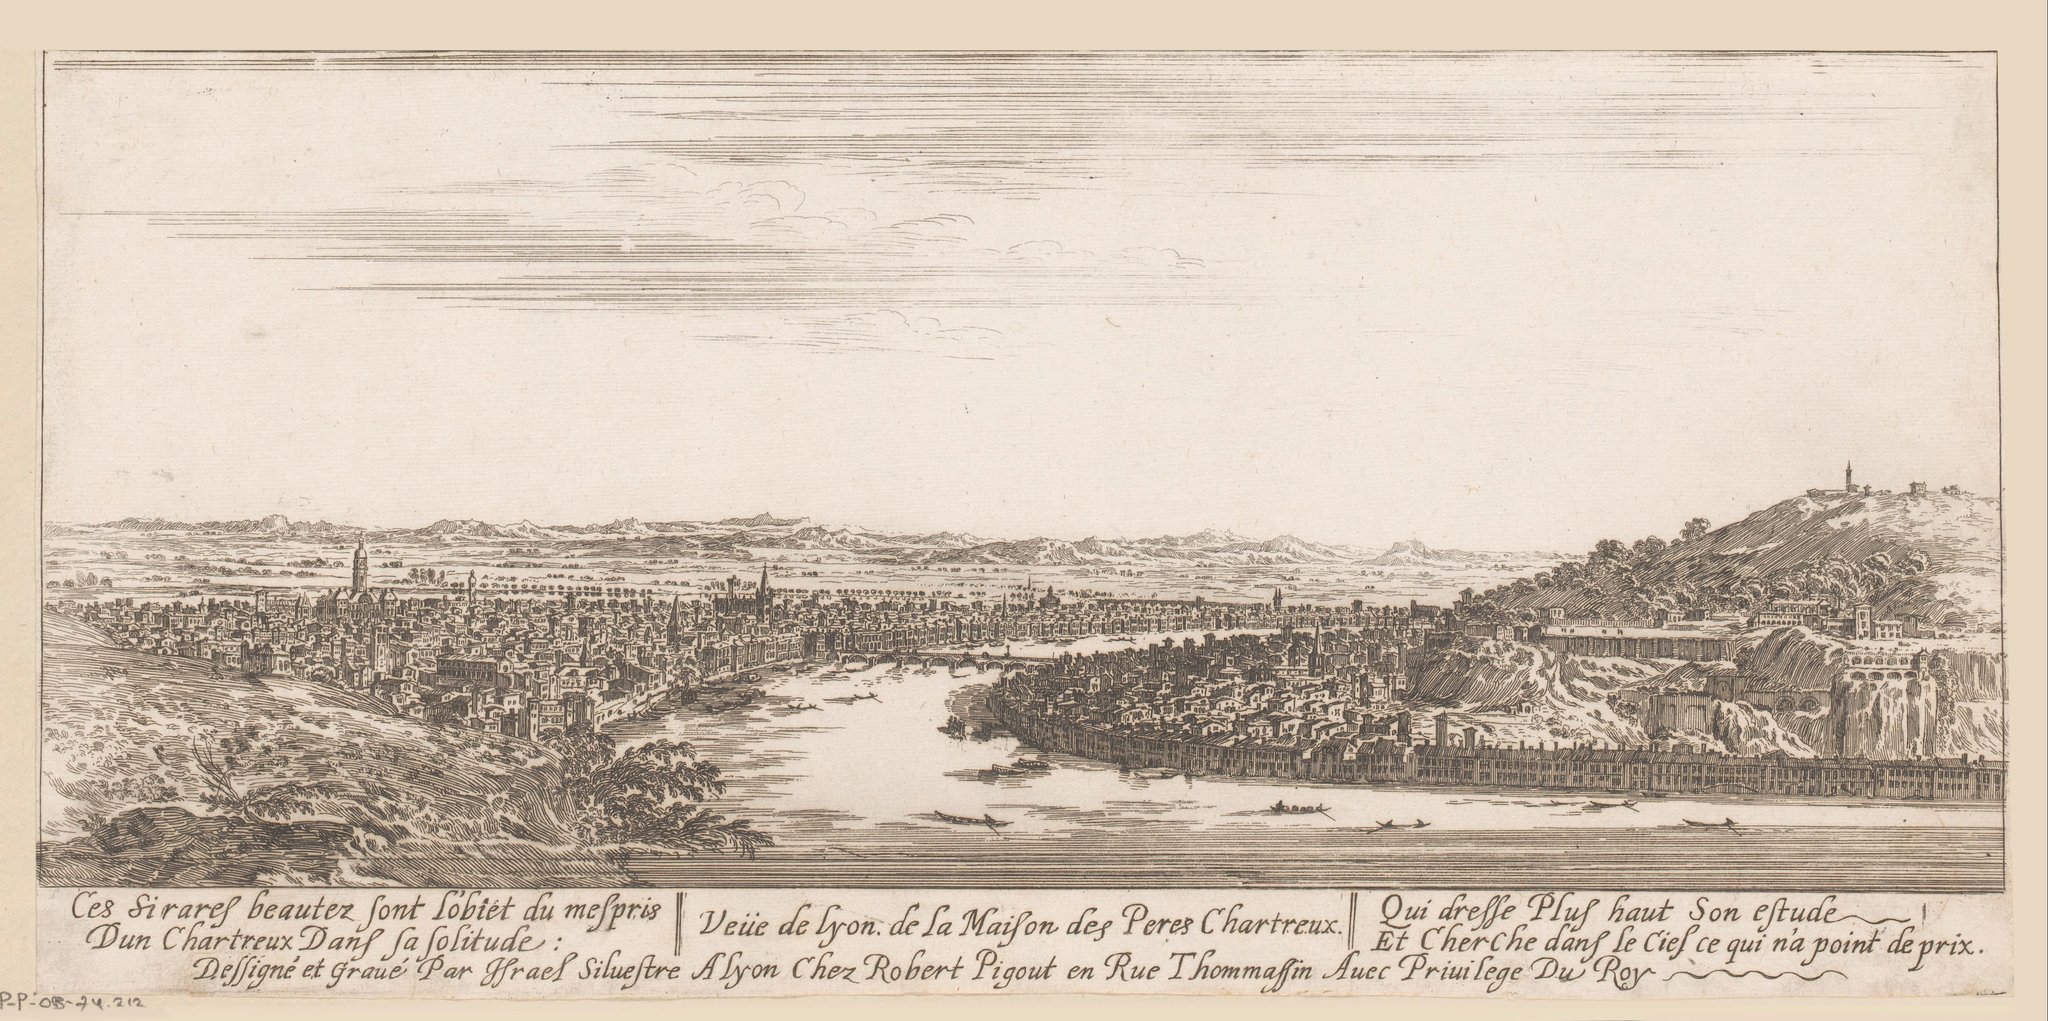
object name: print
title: Veue de Lyon de la Maison des Peres Chartreux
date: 1631-1691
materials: paper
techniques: engraving, etching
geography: france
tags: city-view, and landscape with man-made constructions, lyon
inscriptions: collector's mark: Lugt 240